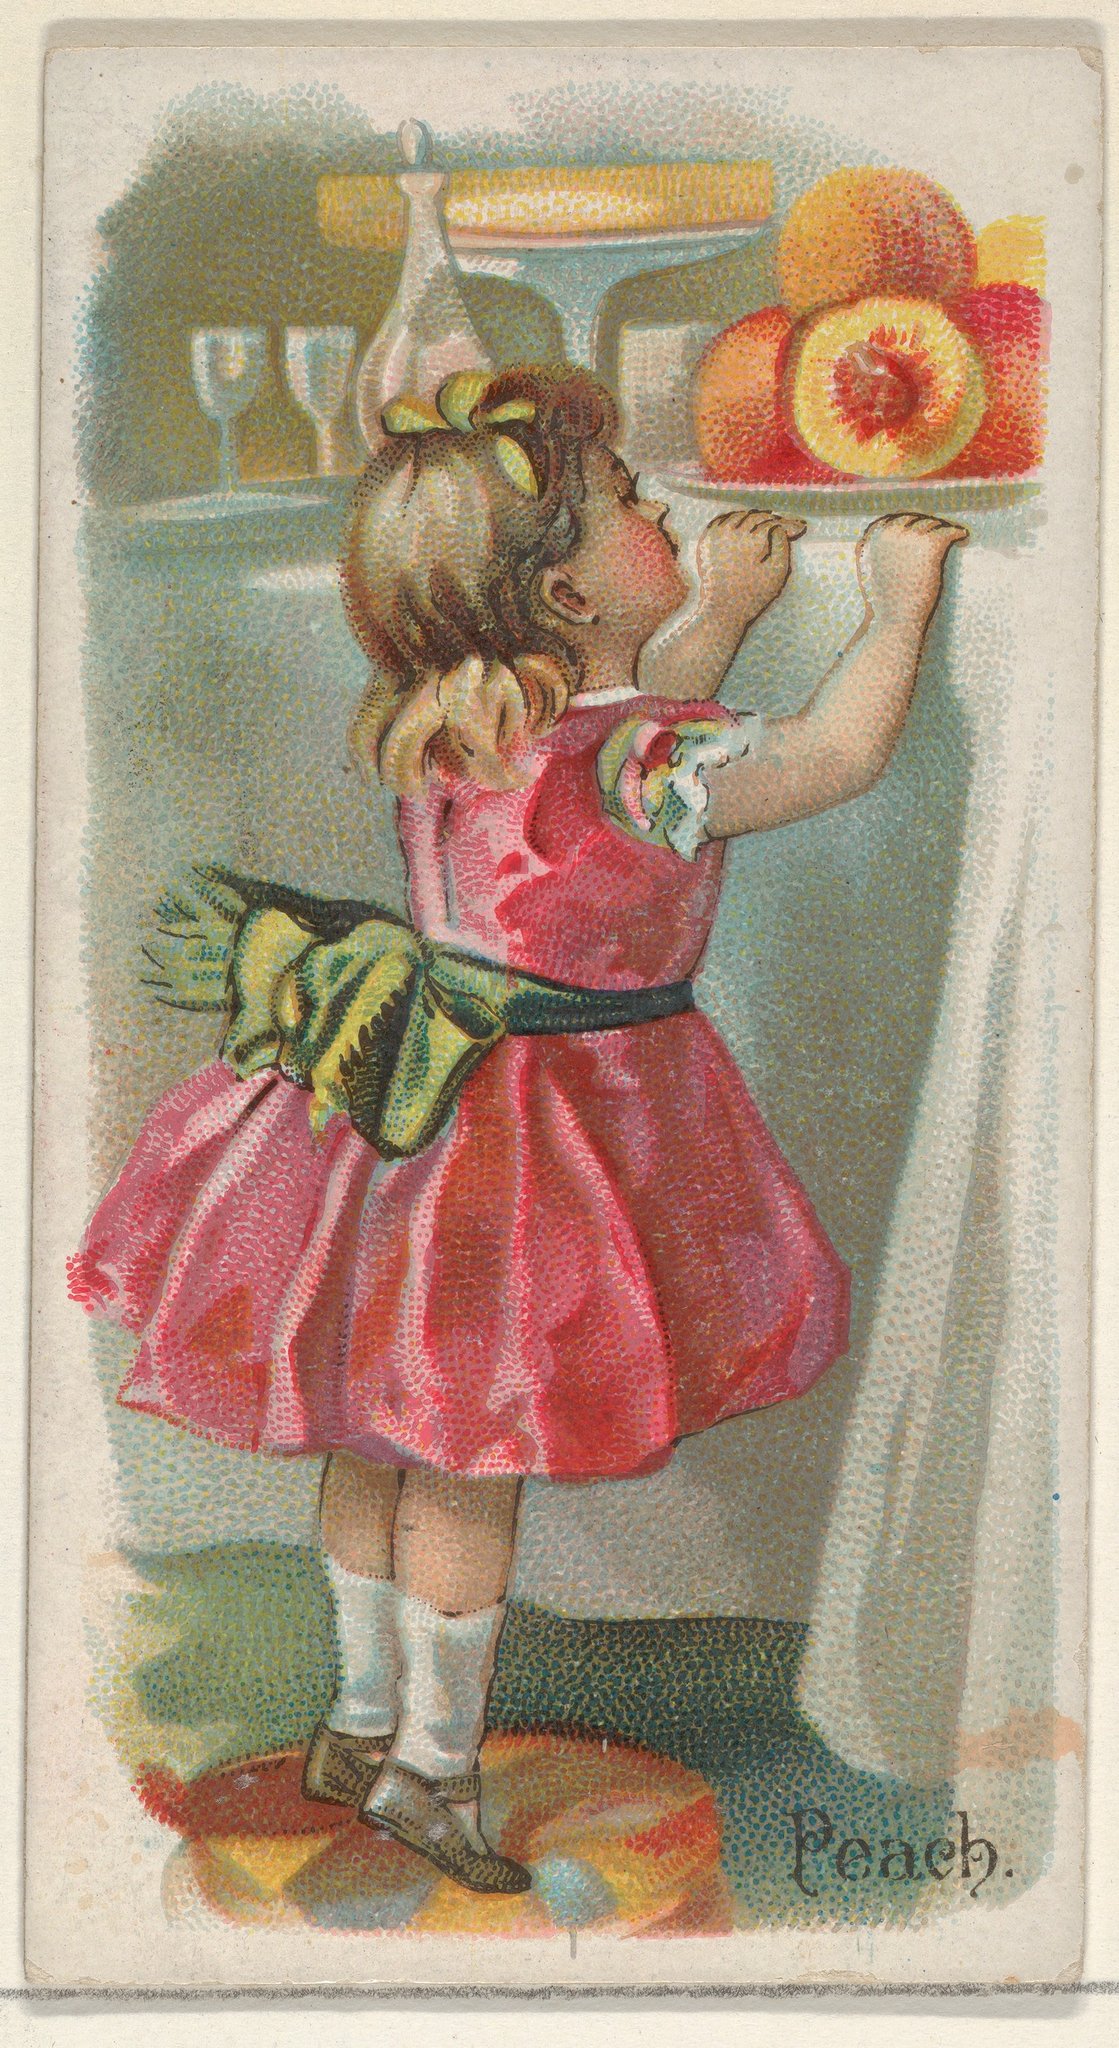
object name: print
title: Peach, from the Fruits series (N12) for Allen & Ginter Cigarettes Brands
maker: allen & ginter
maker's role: publisher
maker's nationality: american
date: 1891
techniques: color lithograph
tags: peaches,girls